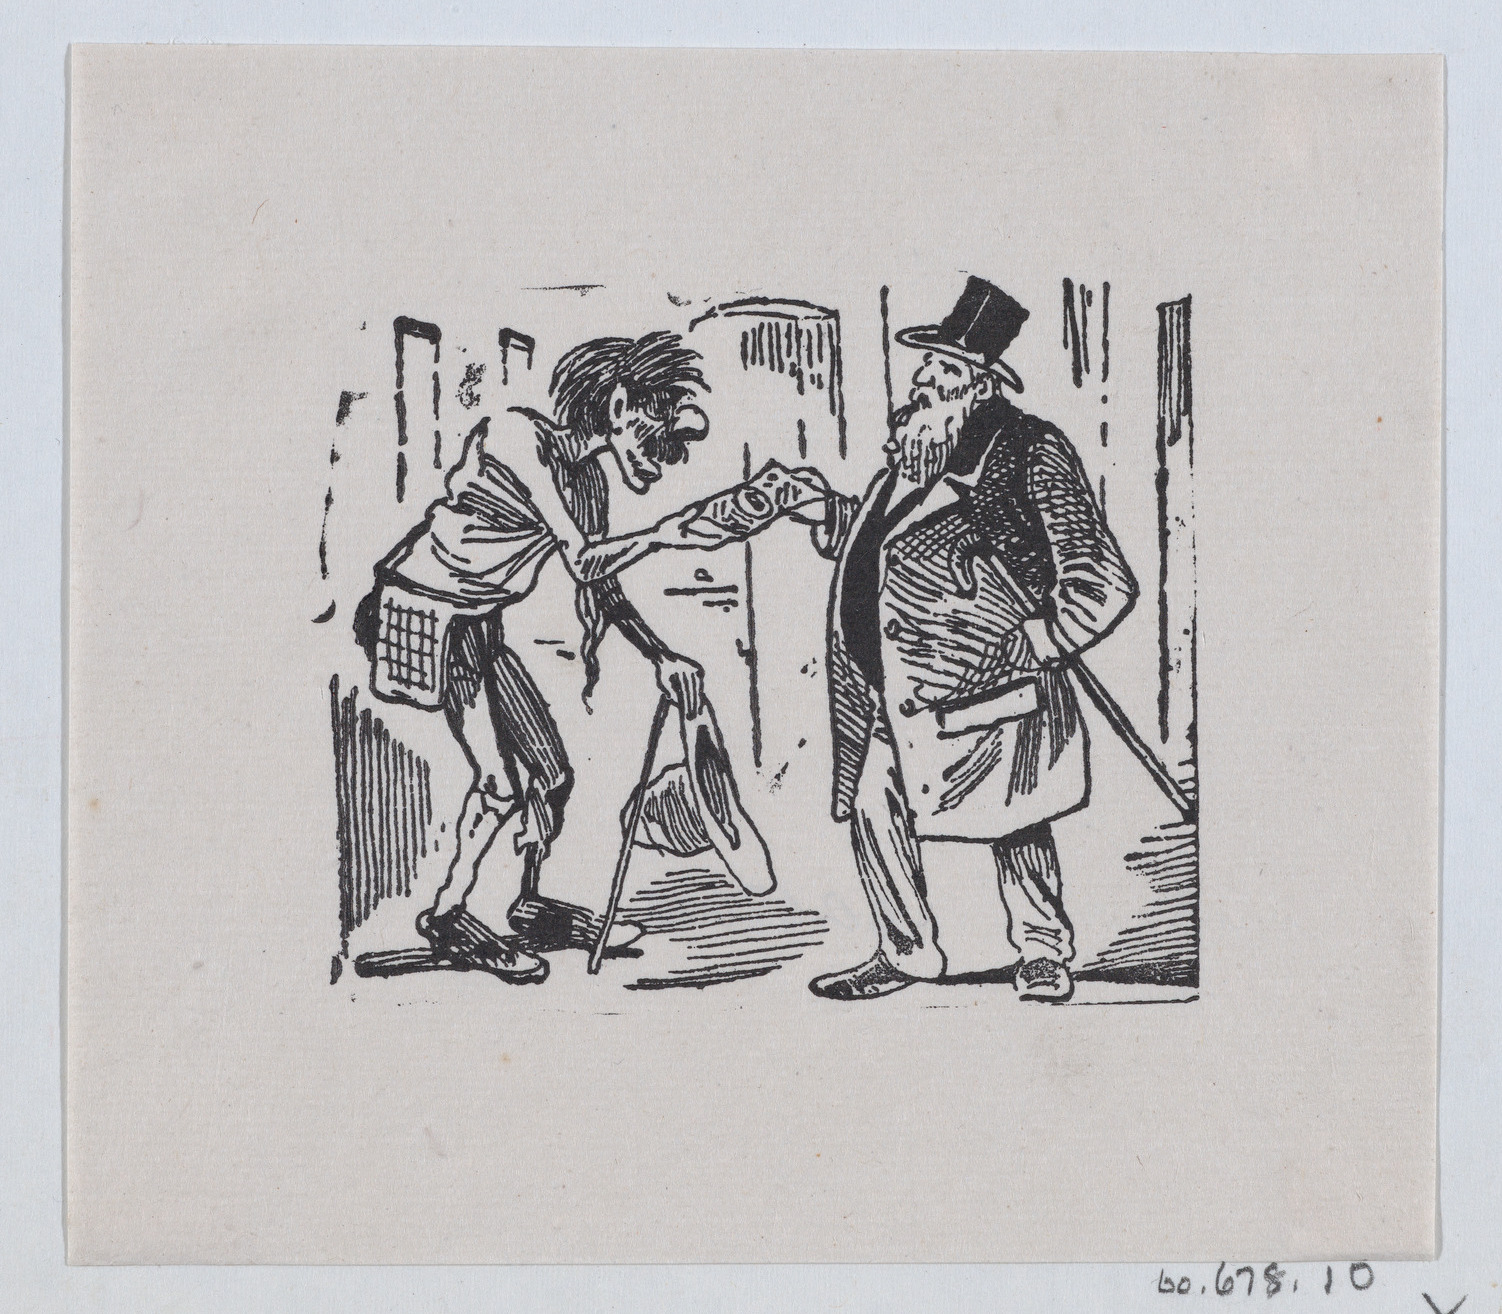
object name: print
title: A rich man giving a beggar money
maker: josé guadalupe posada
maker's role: artist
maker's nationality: mexican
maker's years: 1852-1913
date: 1880-1910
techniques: lithography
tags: men,money